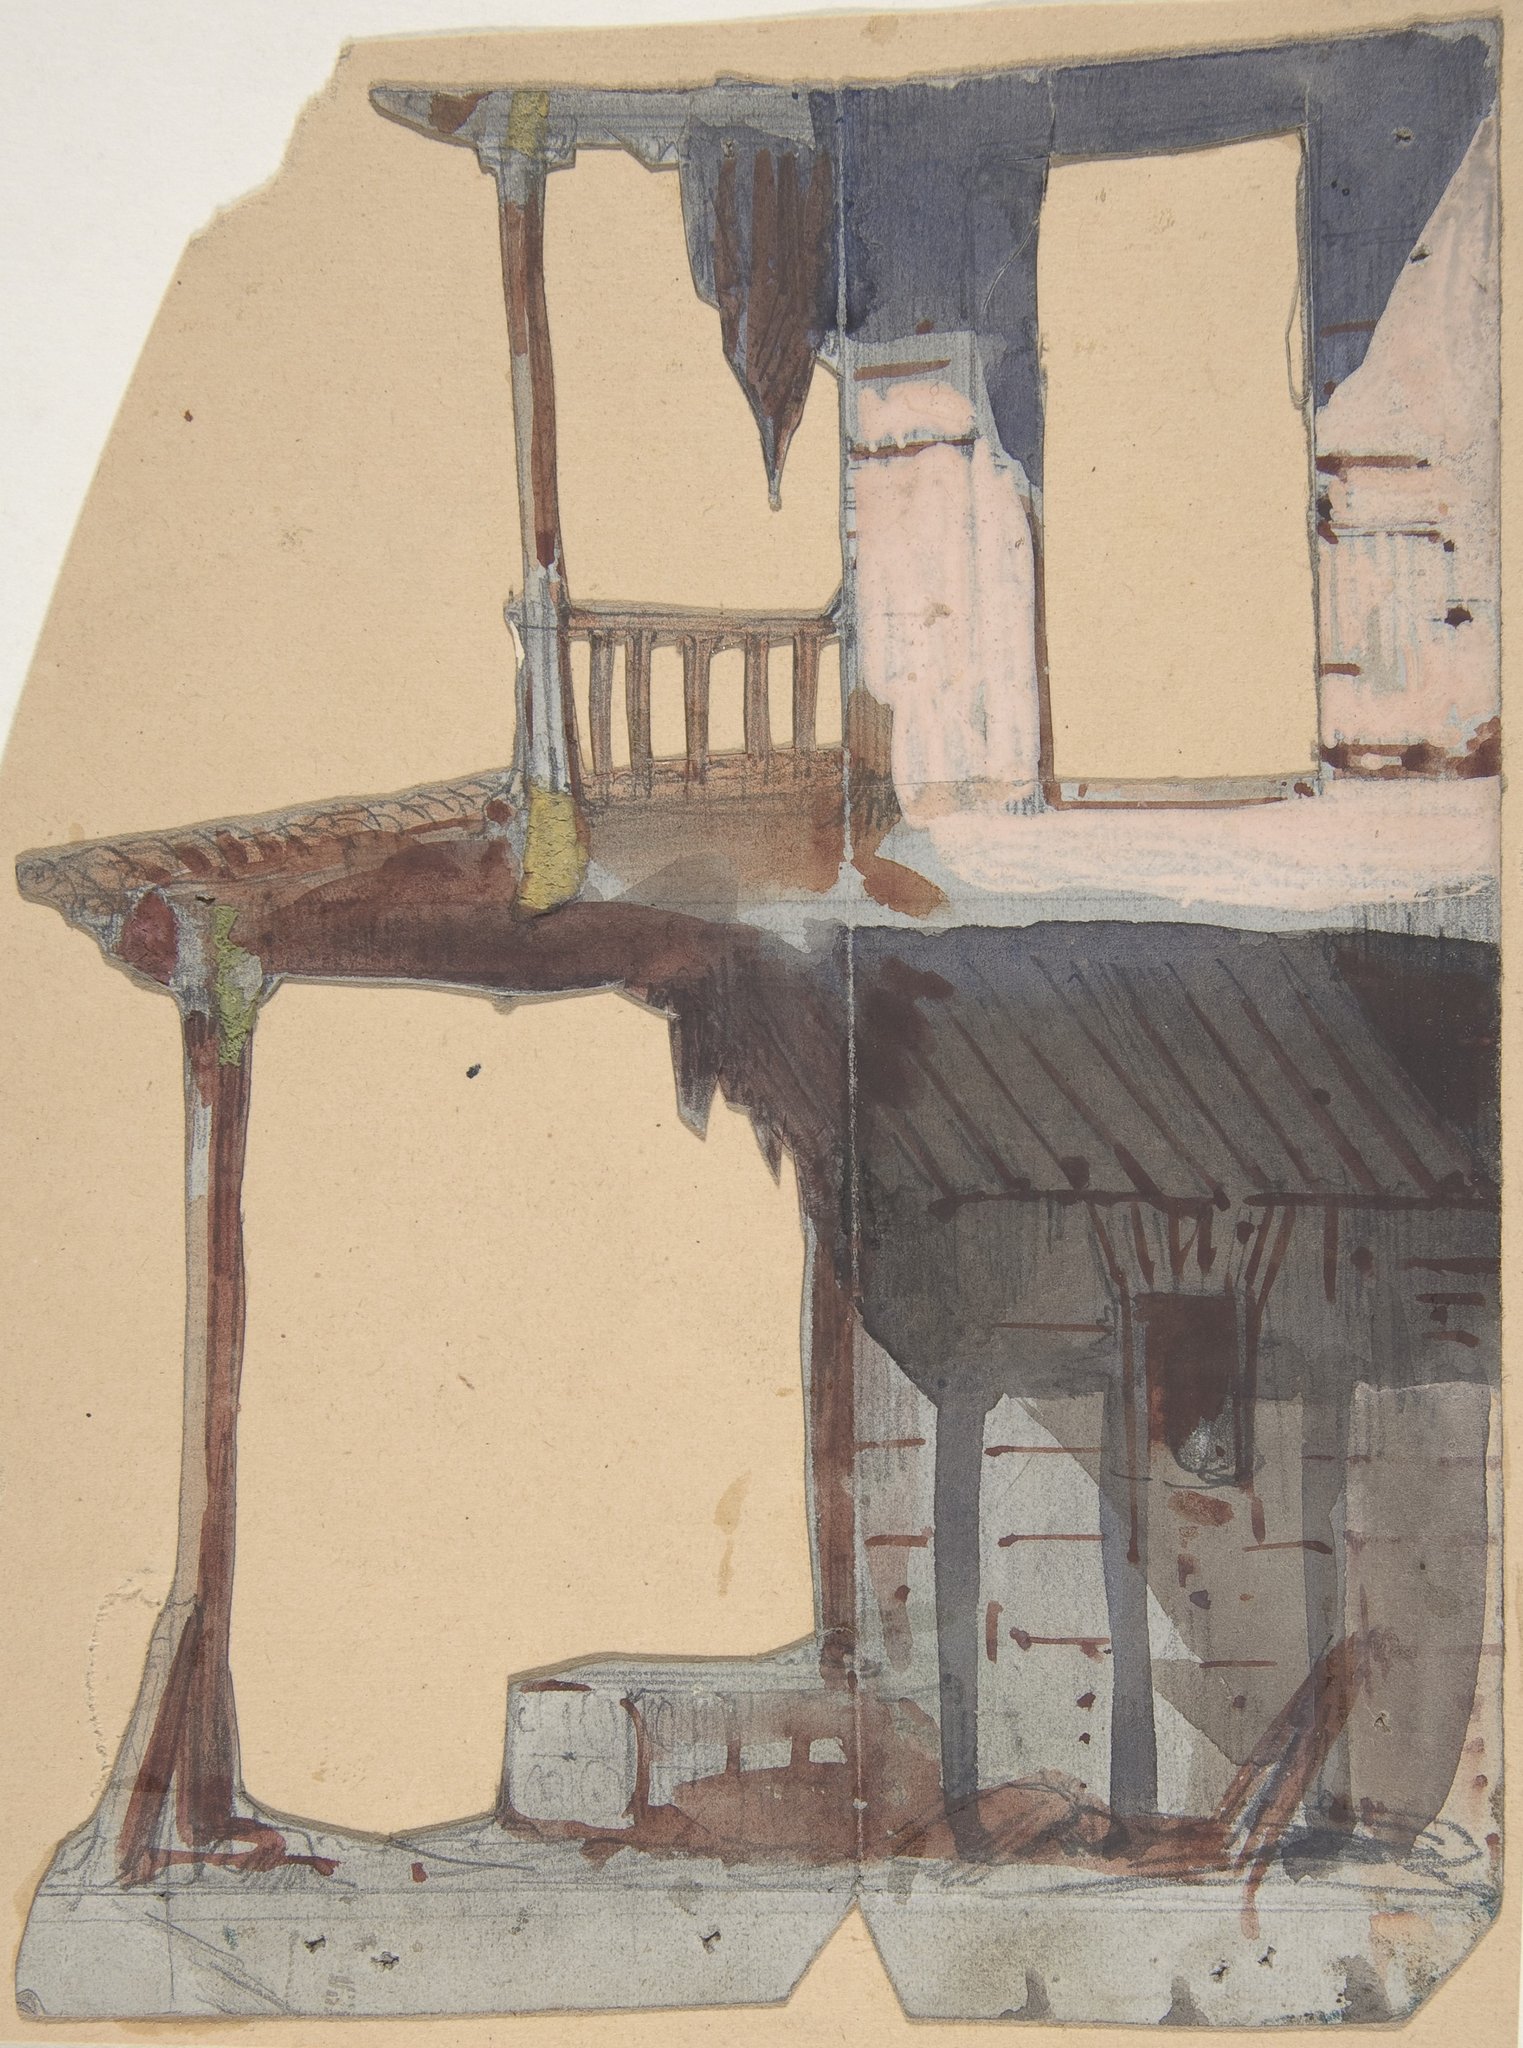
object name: drawing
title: Design for a Stage Set at the Opéra, Paris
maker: eugène cicéri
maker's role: artist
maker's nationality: french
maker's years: 1813-1890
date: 1830-1890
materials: gouache, graphite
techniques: brush, wash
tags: buildings,stage design